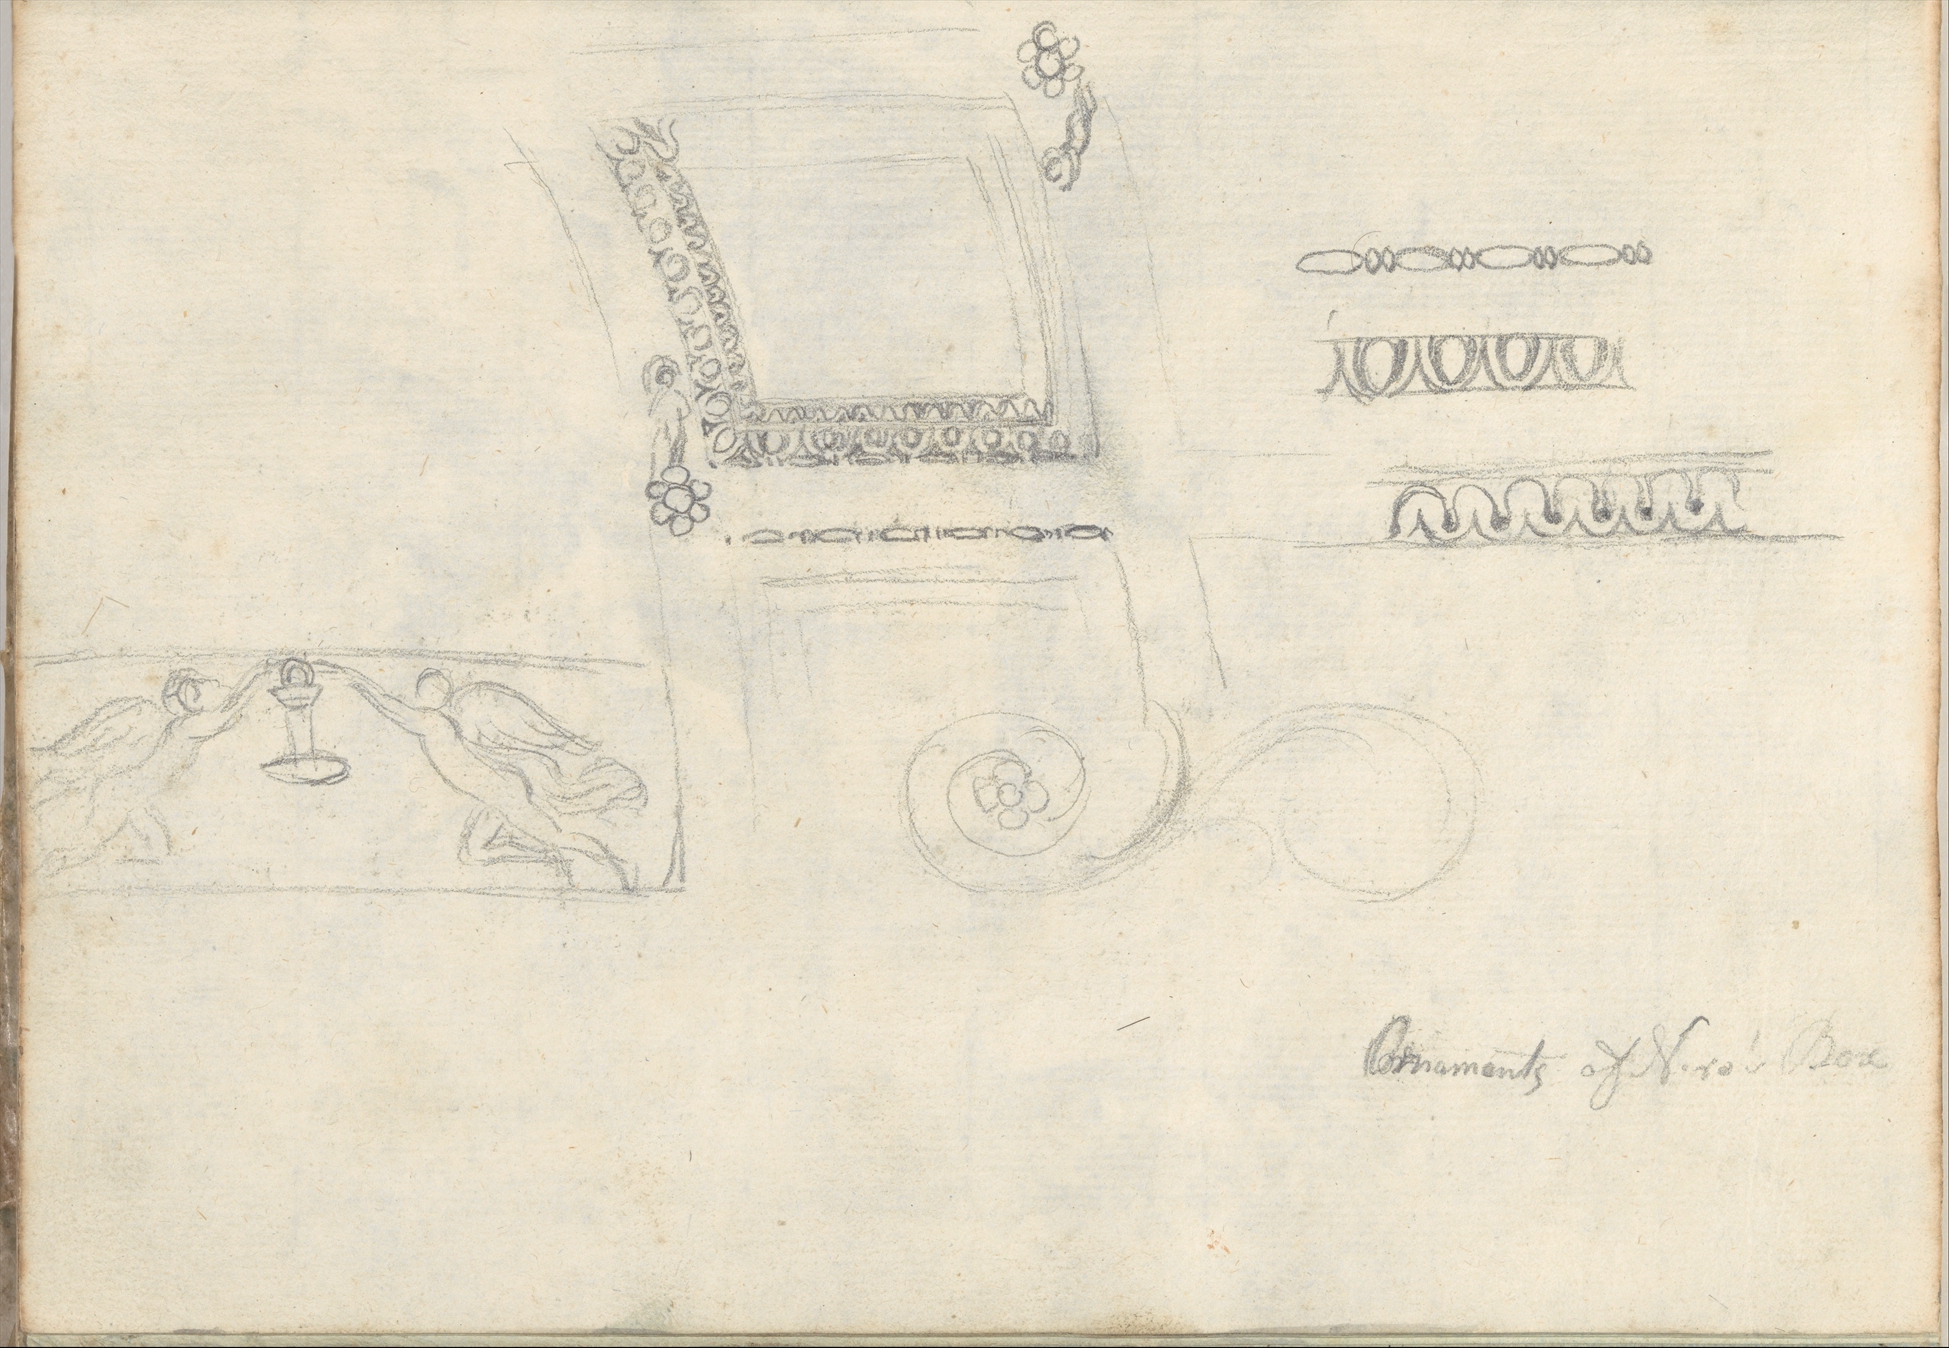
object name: drawing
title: Carved panel and ornament (Smaller Italian sketchbook, leaf 9 recto)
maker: joseph wright (wright of derby)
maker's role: artist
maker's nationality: british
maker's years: 1734-1797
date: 1774-1775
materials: graphite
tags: ornament